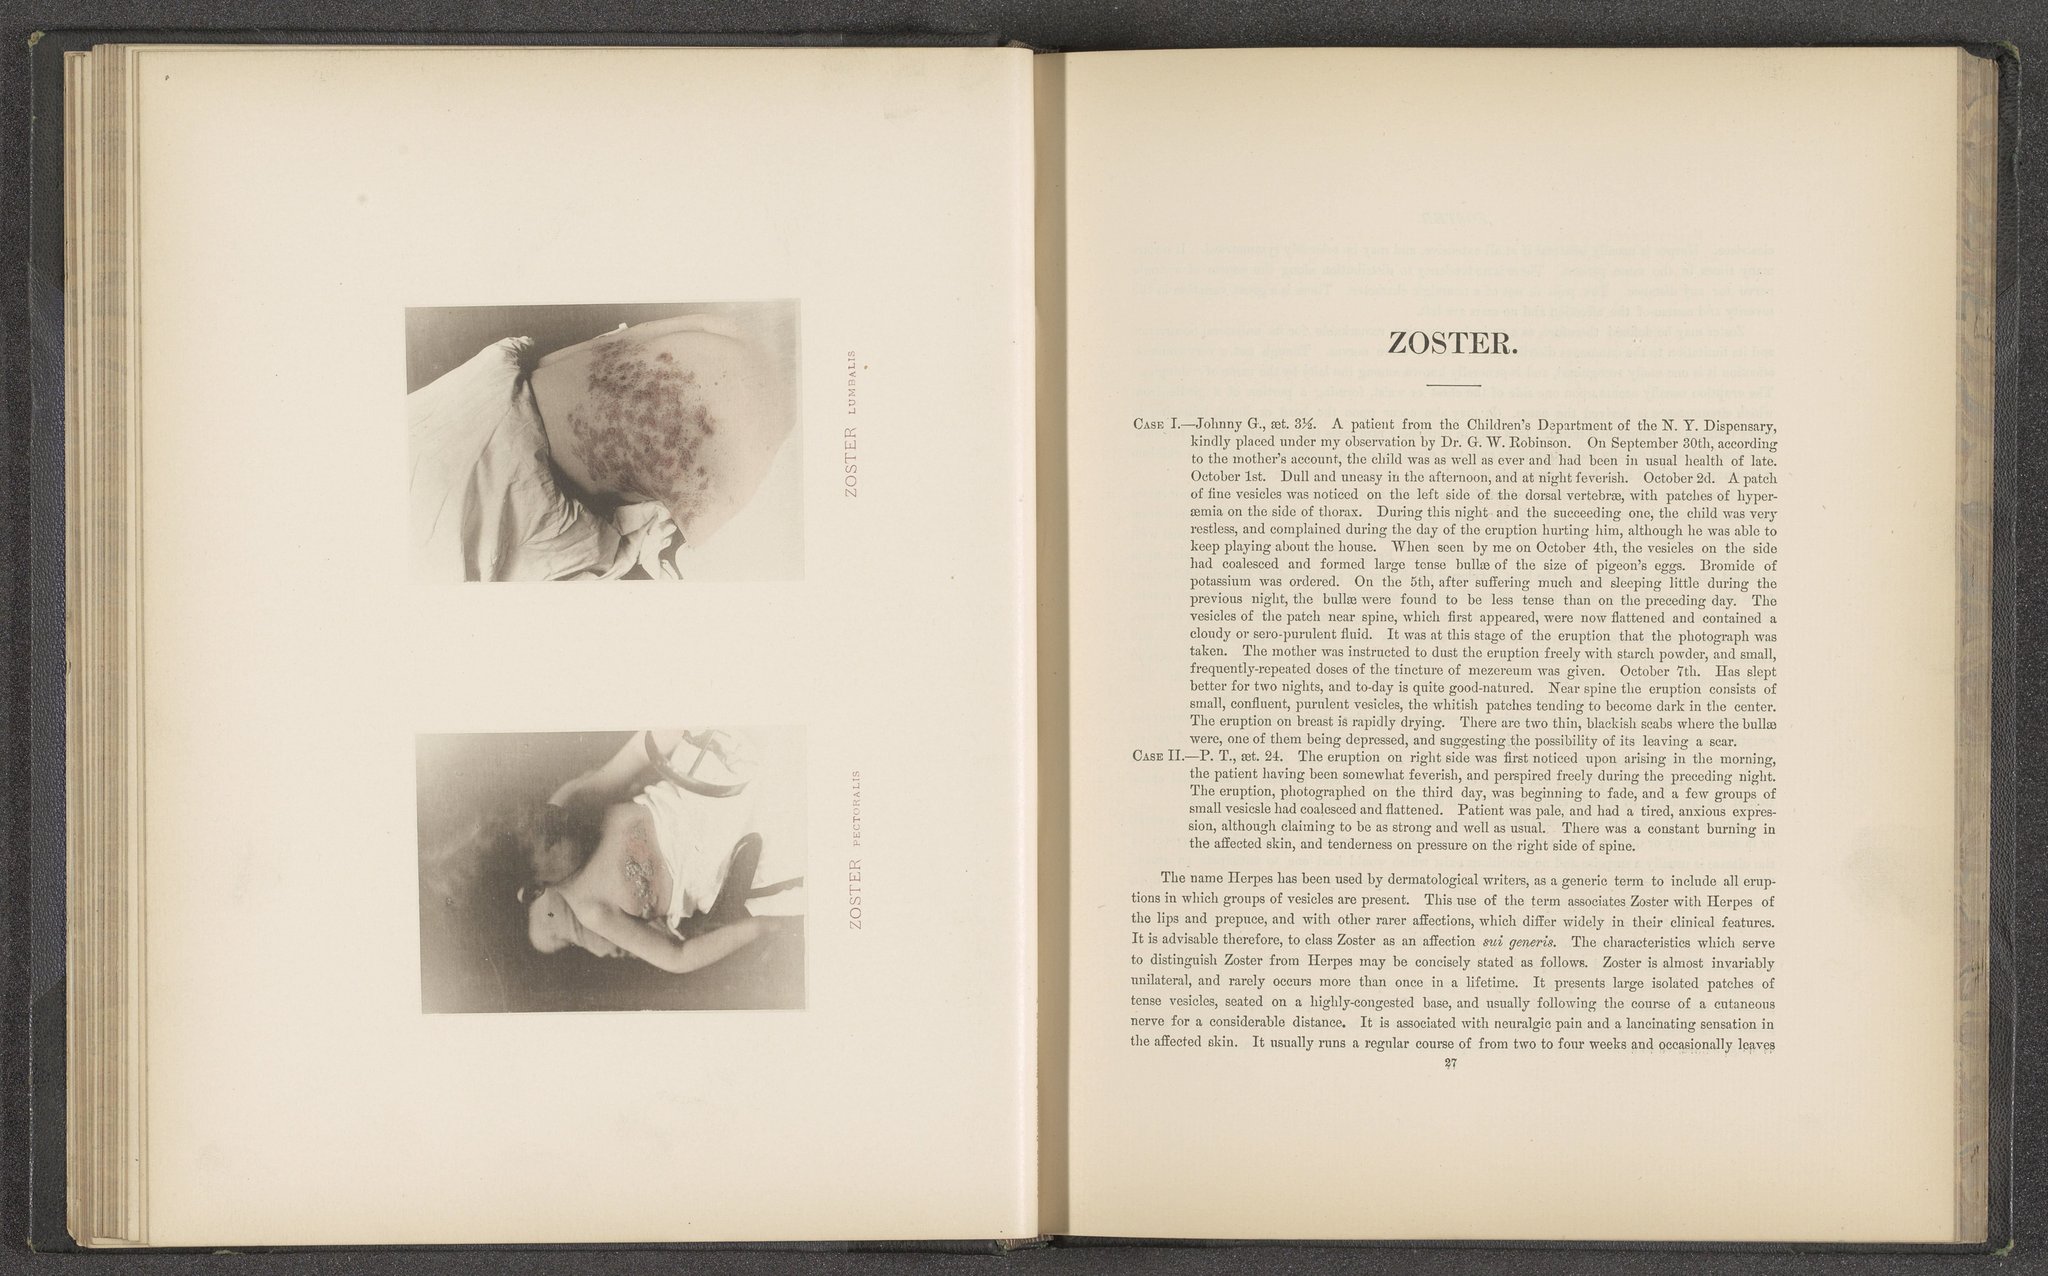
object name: page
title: Patiënten lijdend aan de huidziekte 'zoster pectoralis' en 'zoster lumbalis'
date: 1870-1881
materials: paper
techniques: photograph, hand coloring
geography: new york city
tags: skin and venereal diseases, child